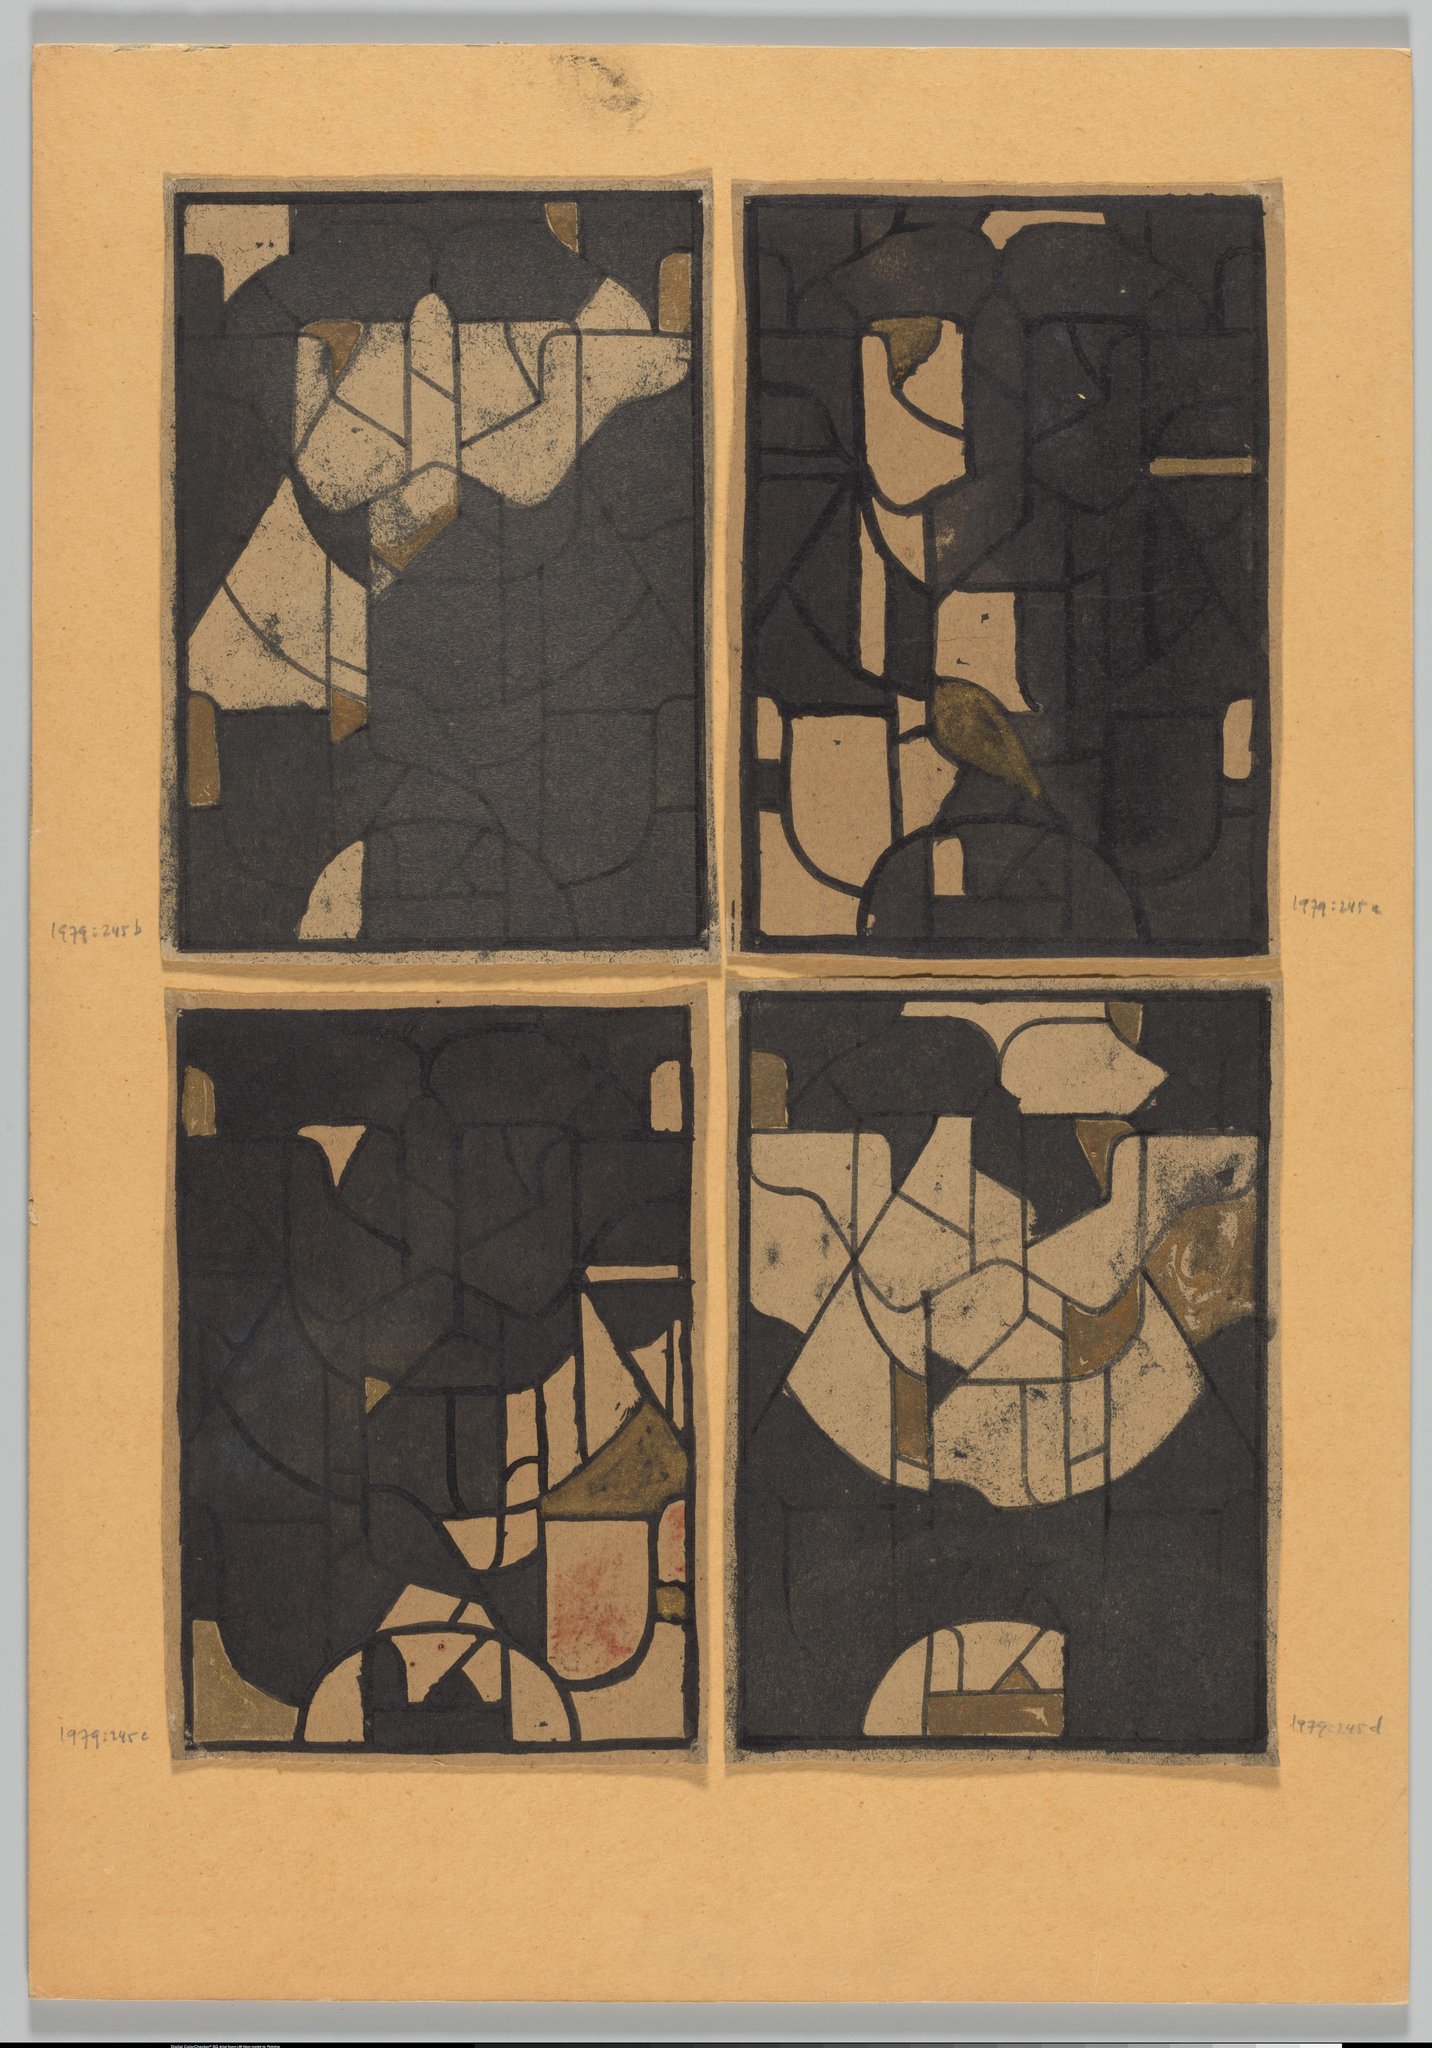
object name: design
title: Tapijtontwerp voor raam in het Noordertransept van de Dom te Utrecht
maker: richard nicolaüs roland holst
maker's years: 1868-1938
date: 1868-1938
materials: cardboard, paper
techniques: brush